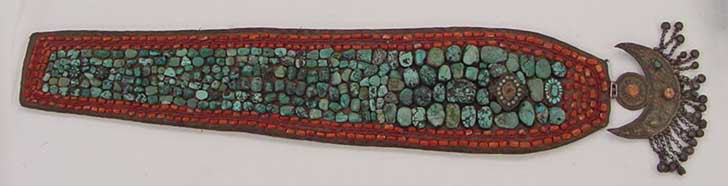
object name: headdress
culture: indian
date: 1801-1900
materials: coral, cotton, metal